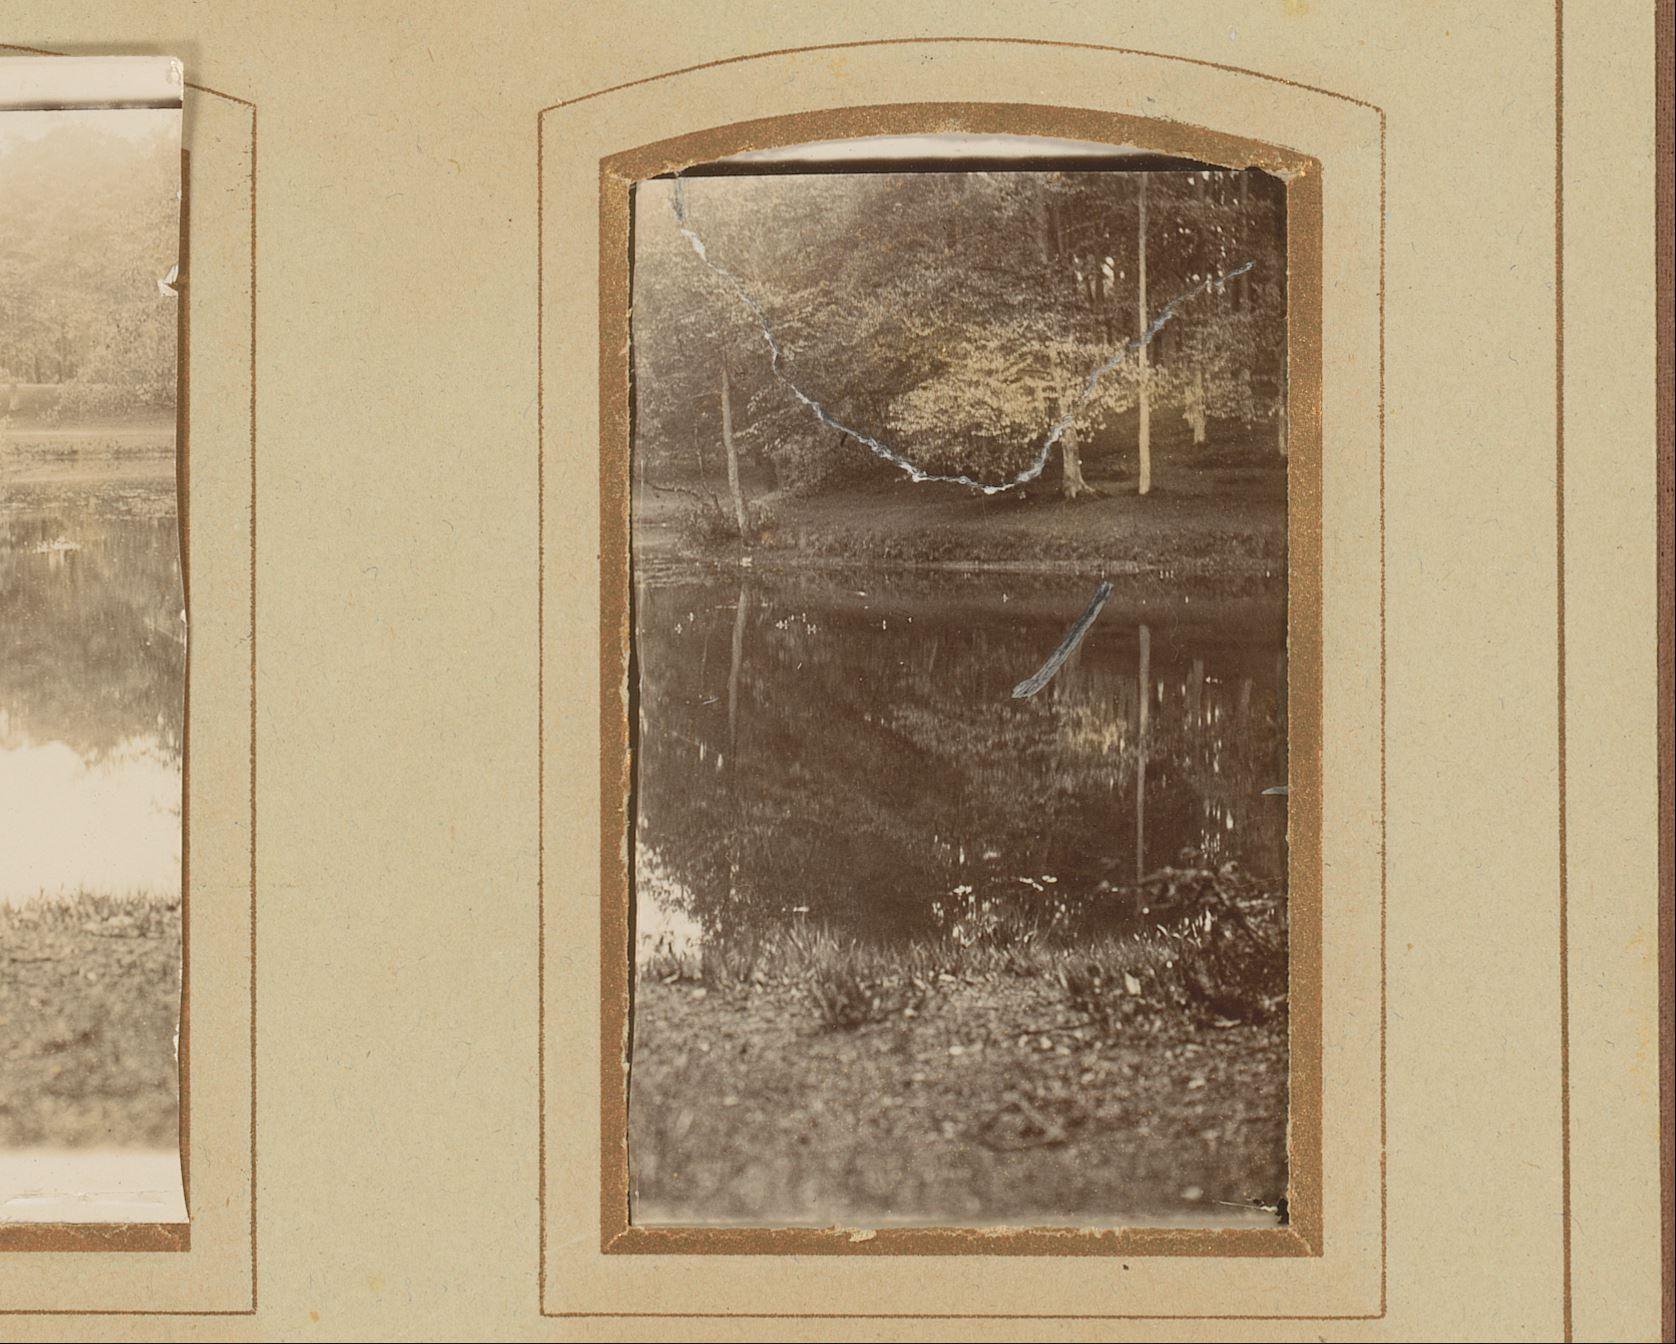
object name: album leaf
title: Gezicht op een vijver in het bos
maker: Anonymous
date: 1880-1920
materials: photographic support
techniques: gelatin silver print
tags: forest, wood, pond, pool